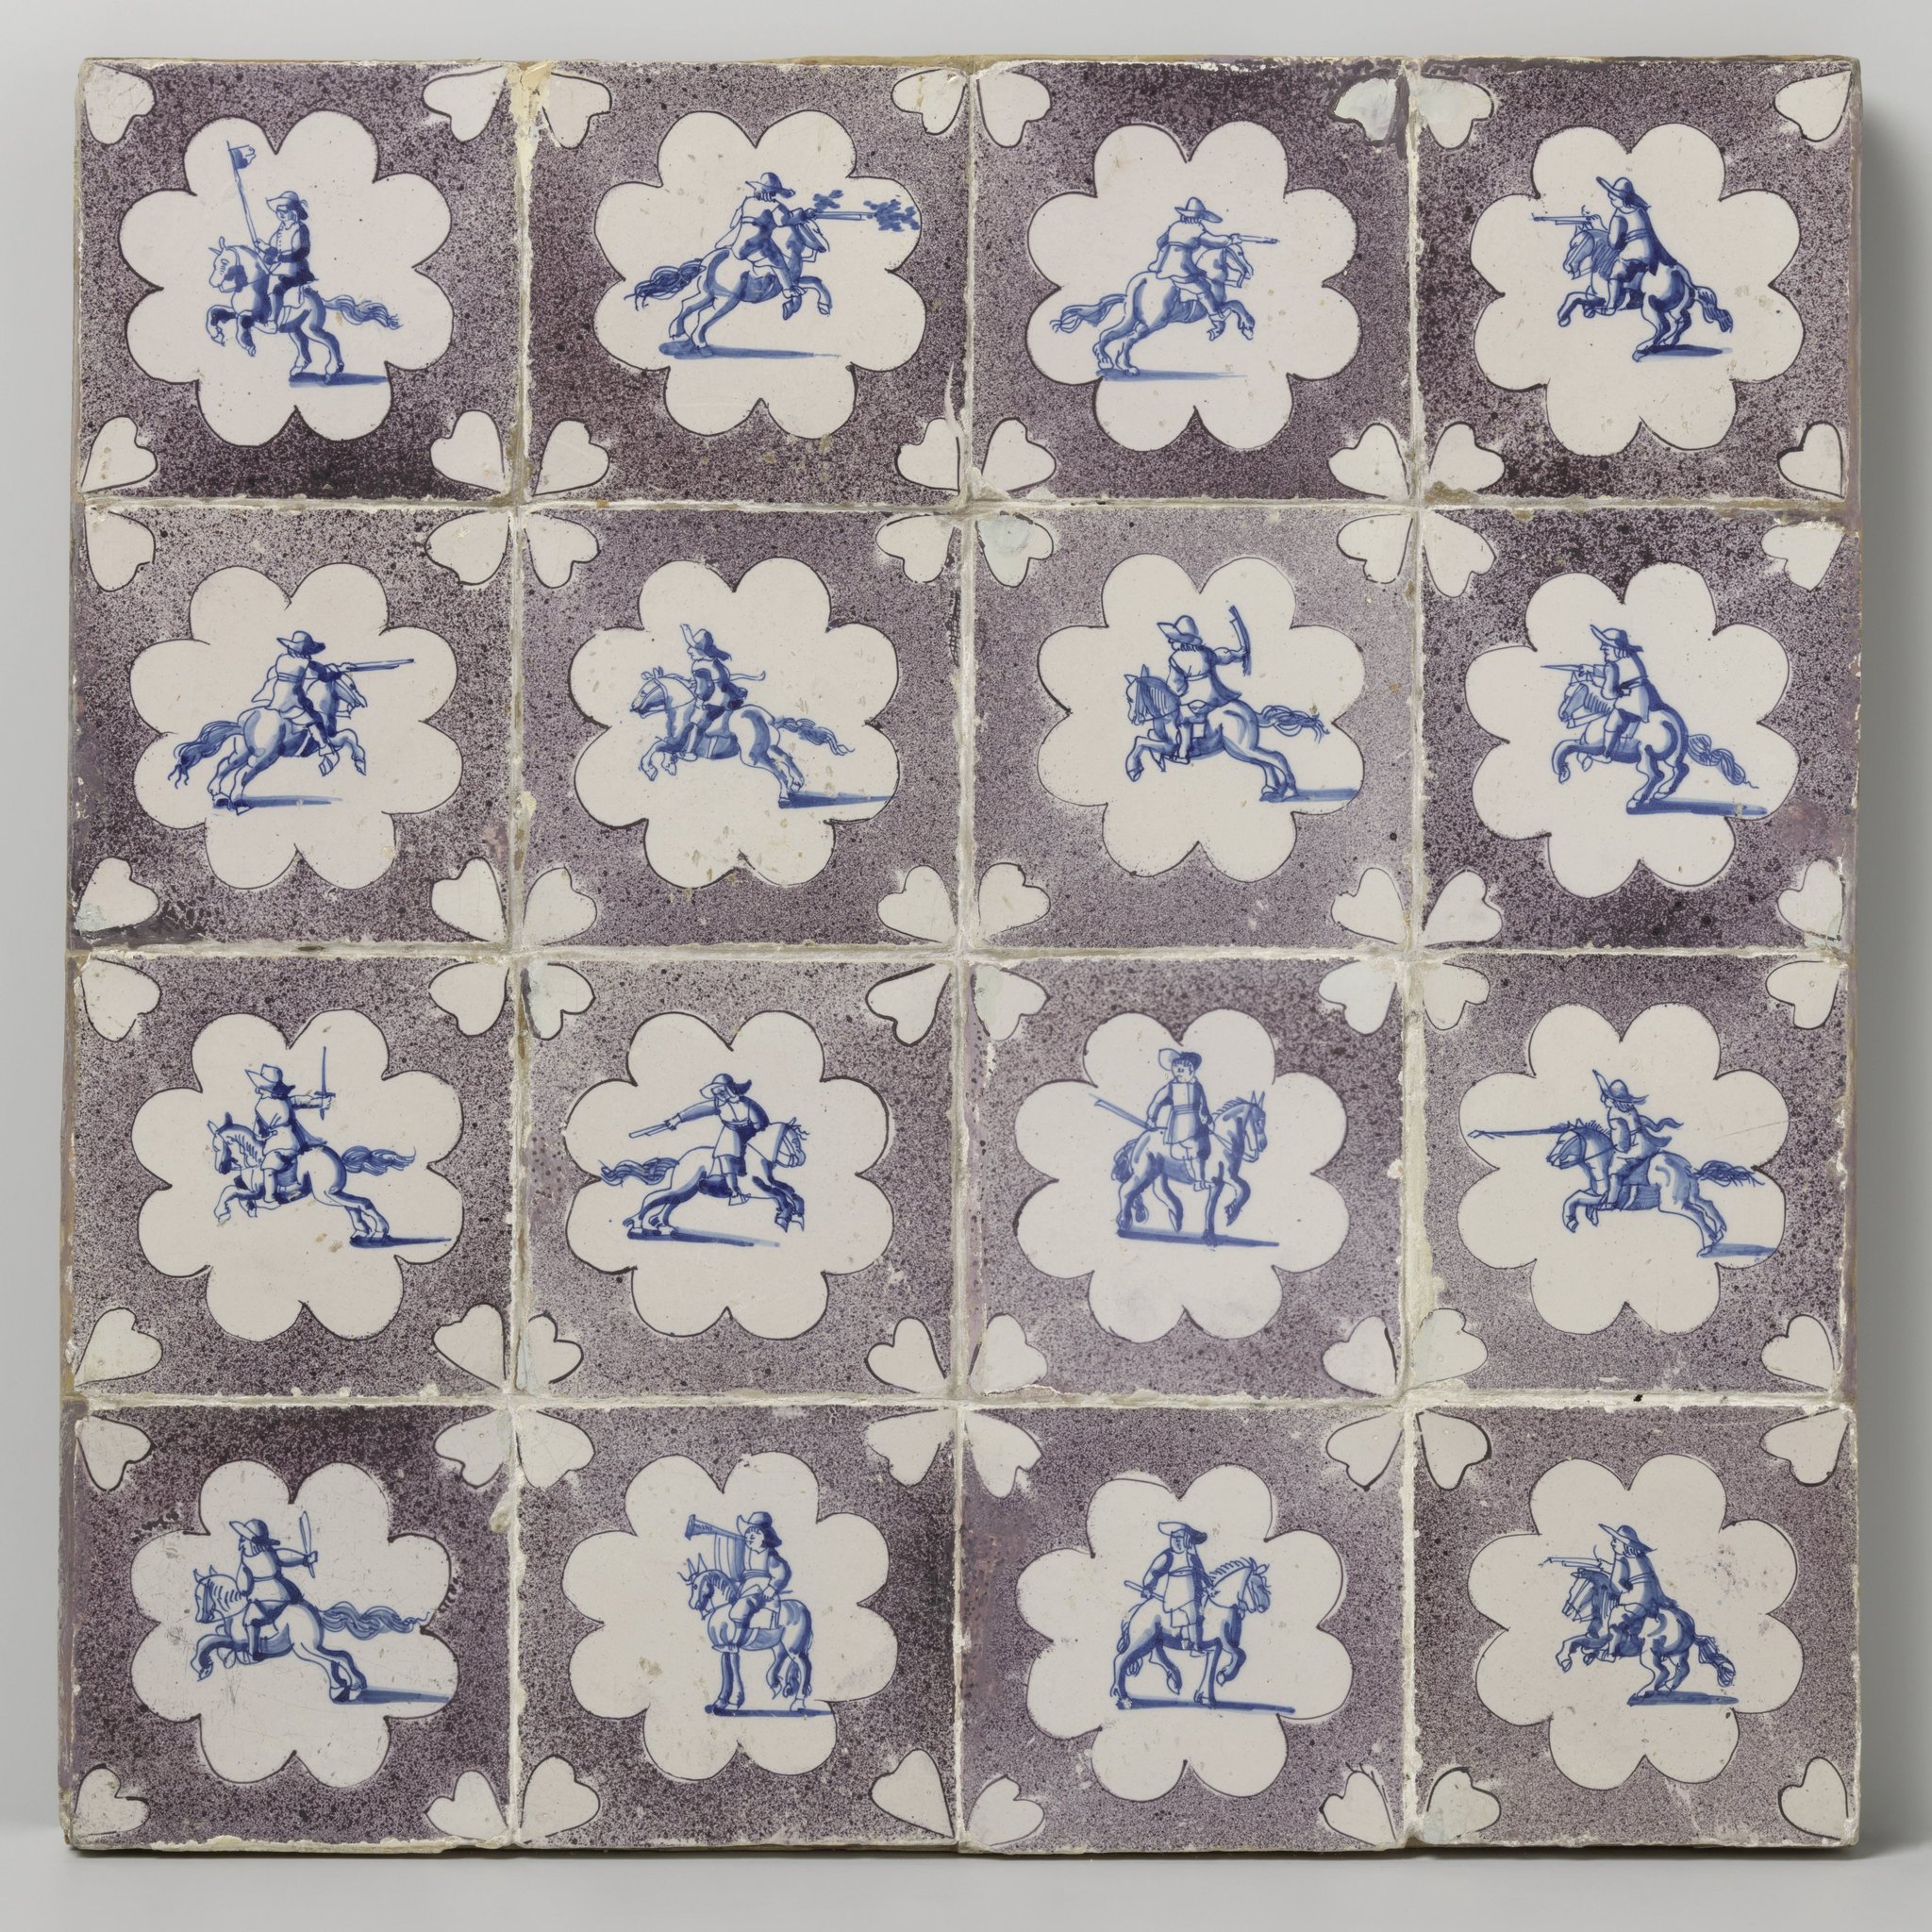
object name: ruitertegel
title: Veld van zestien tegels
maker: Anonymous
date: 1680-1725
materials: earthenware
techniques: maiolica, sprinkling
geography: netherlands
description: Veld van zestien tegels (4 x 4) elk met een blauw geschilderde ruiter binnen een geschulpte cirkel omgeven door geprenkeld paars met in de hoeken, een hart in vultechniek.